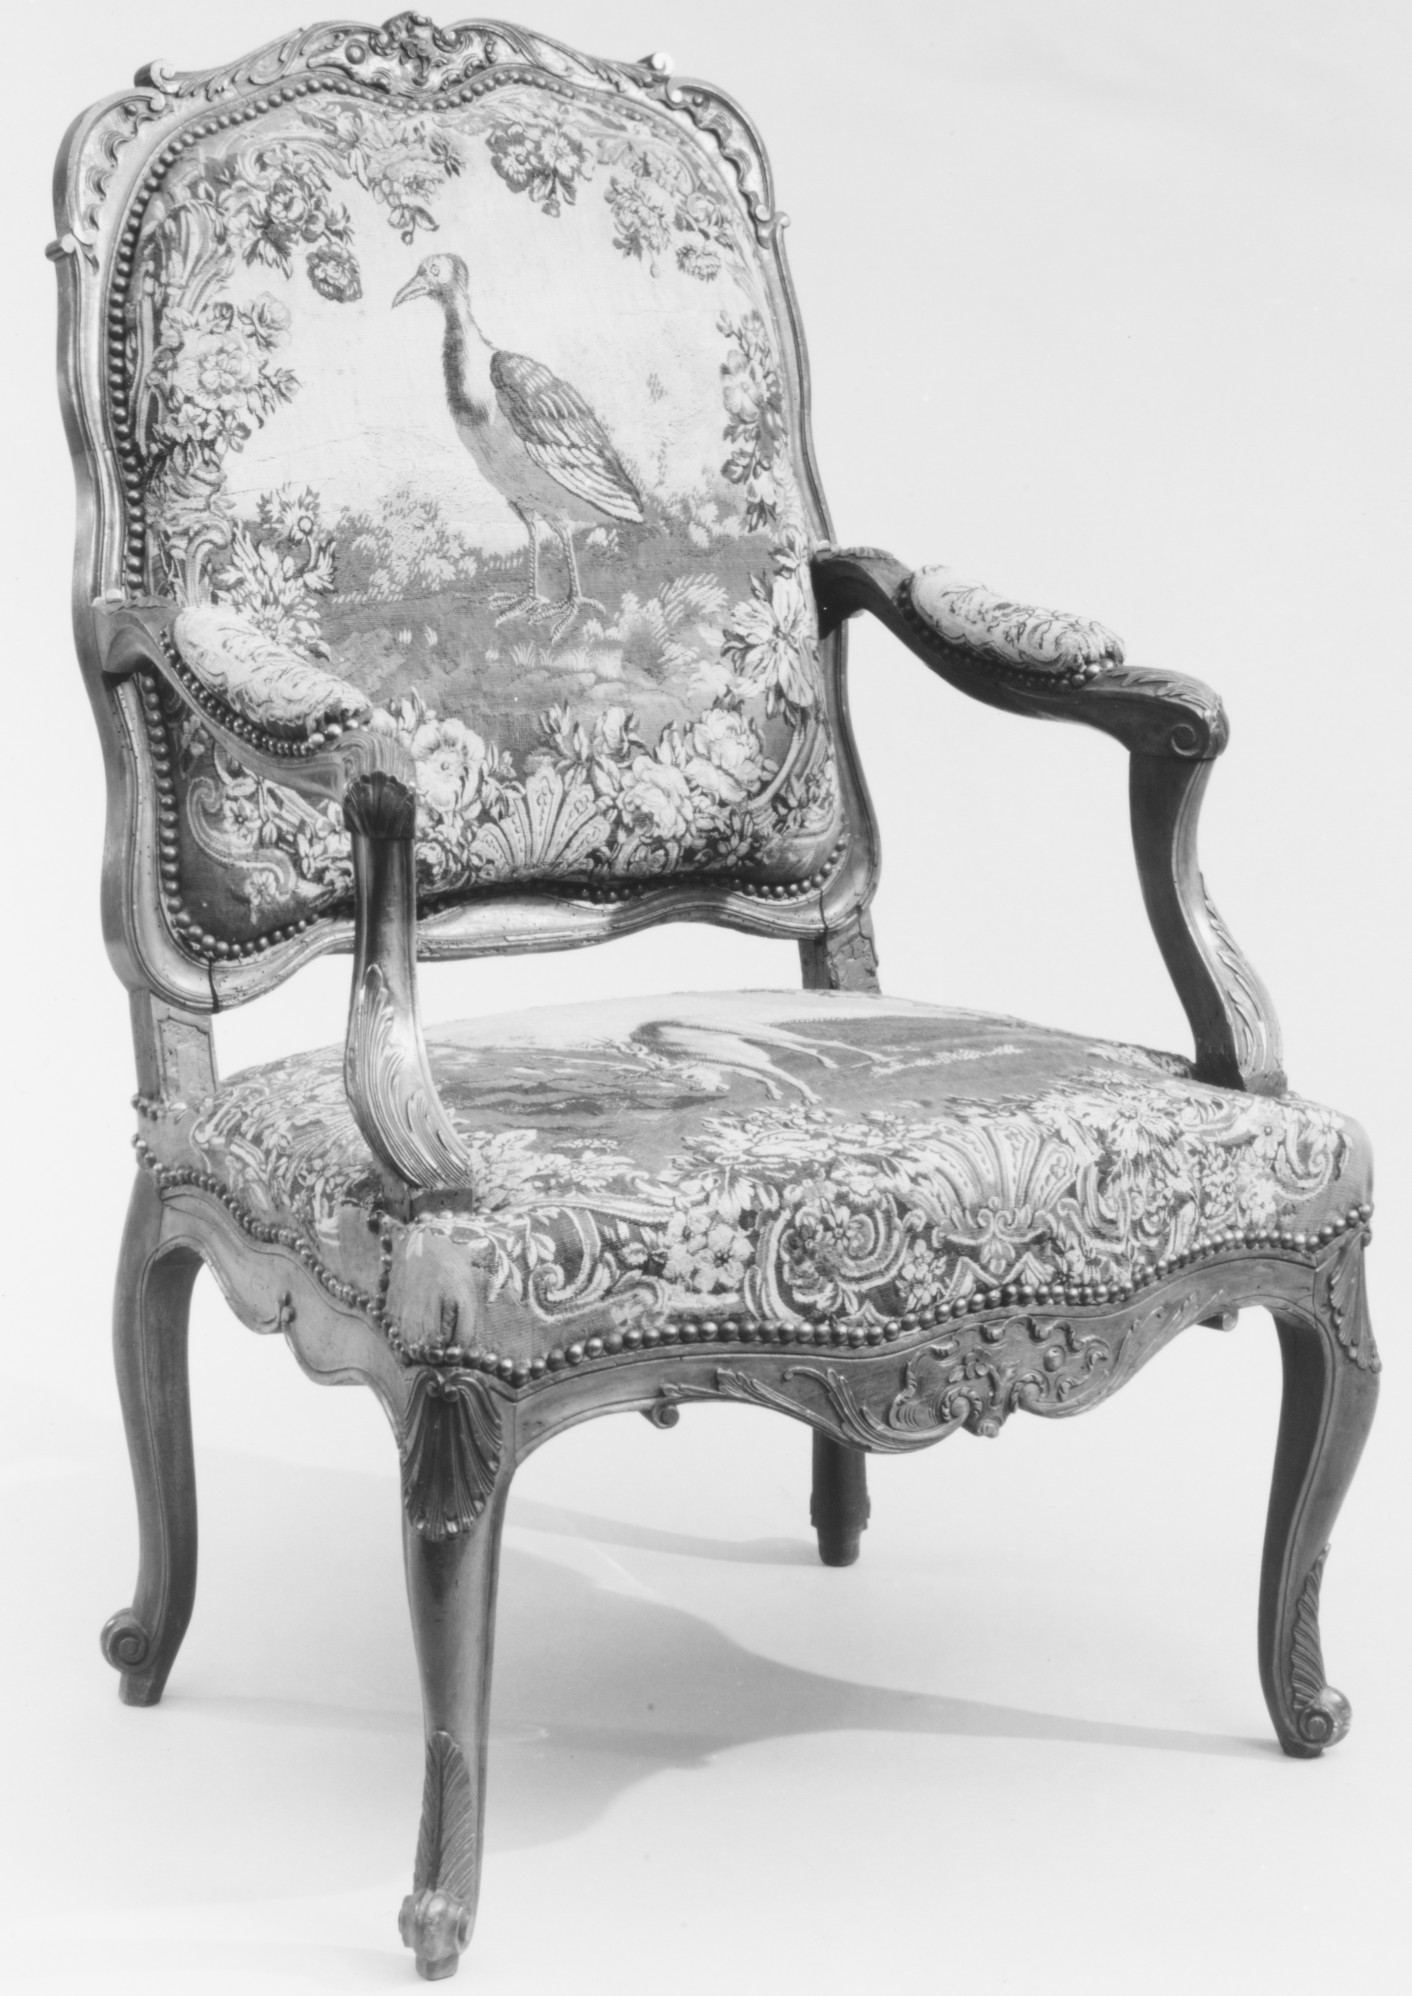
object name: armchair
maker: beauvais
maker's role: factory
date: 1730-1750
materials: wood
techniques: carving, tapestry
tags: birds,deer